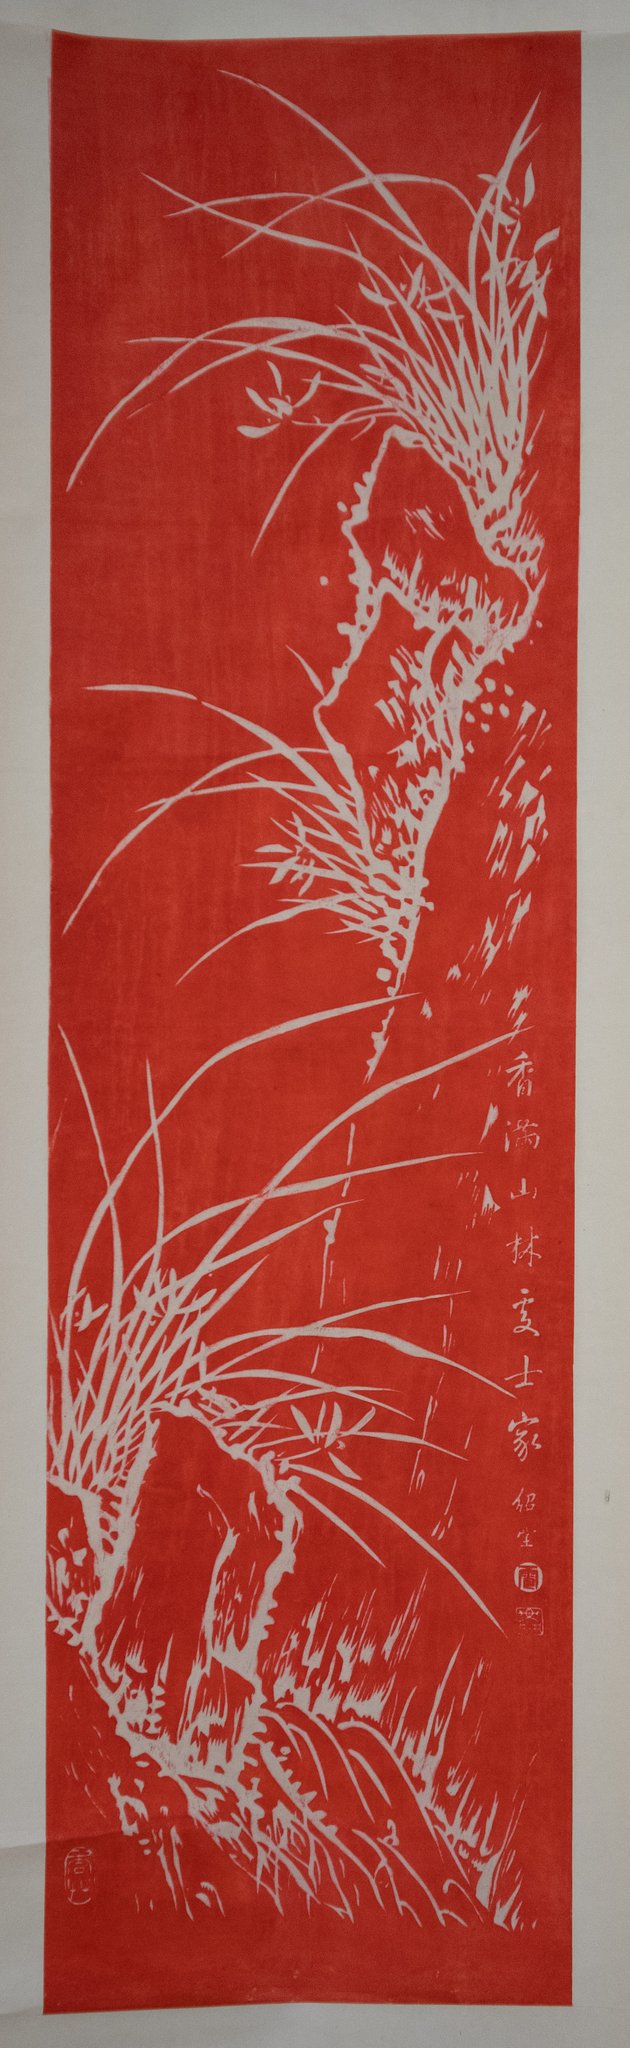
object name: print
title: Orchids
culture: chinese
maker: kuang xü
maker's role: artist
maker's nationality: chinese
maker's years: 1874-1909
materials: ink, paper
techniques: polychrome, woodblock print